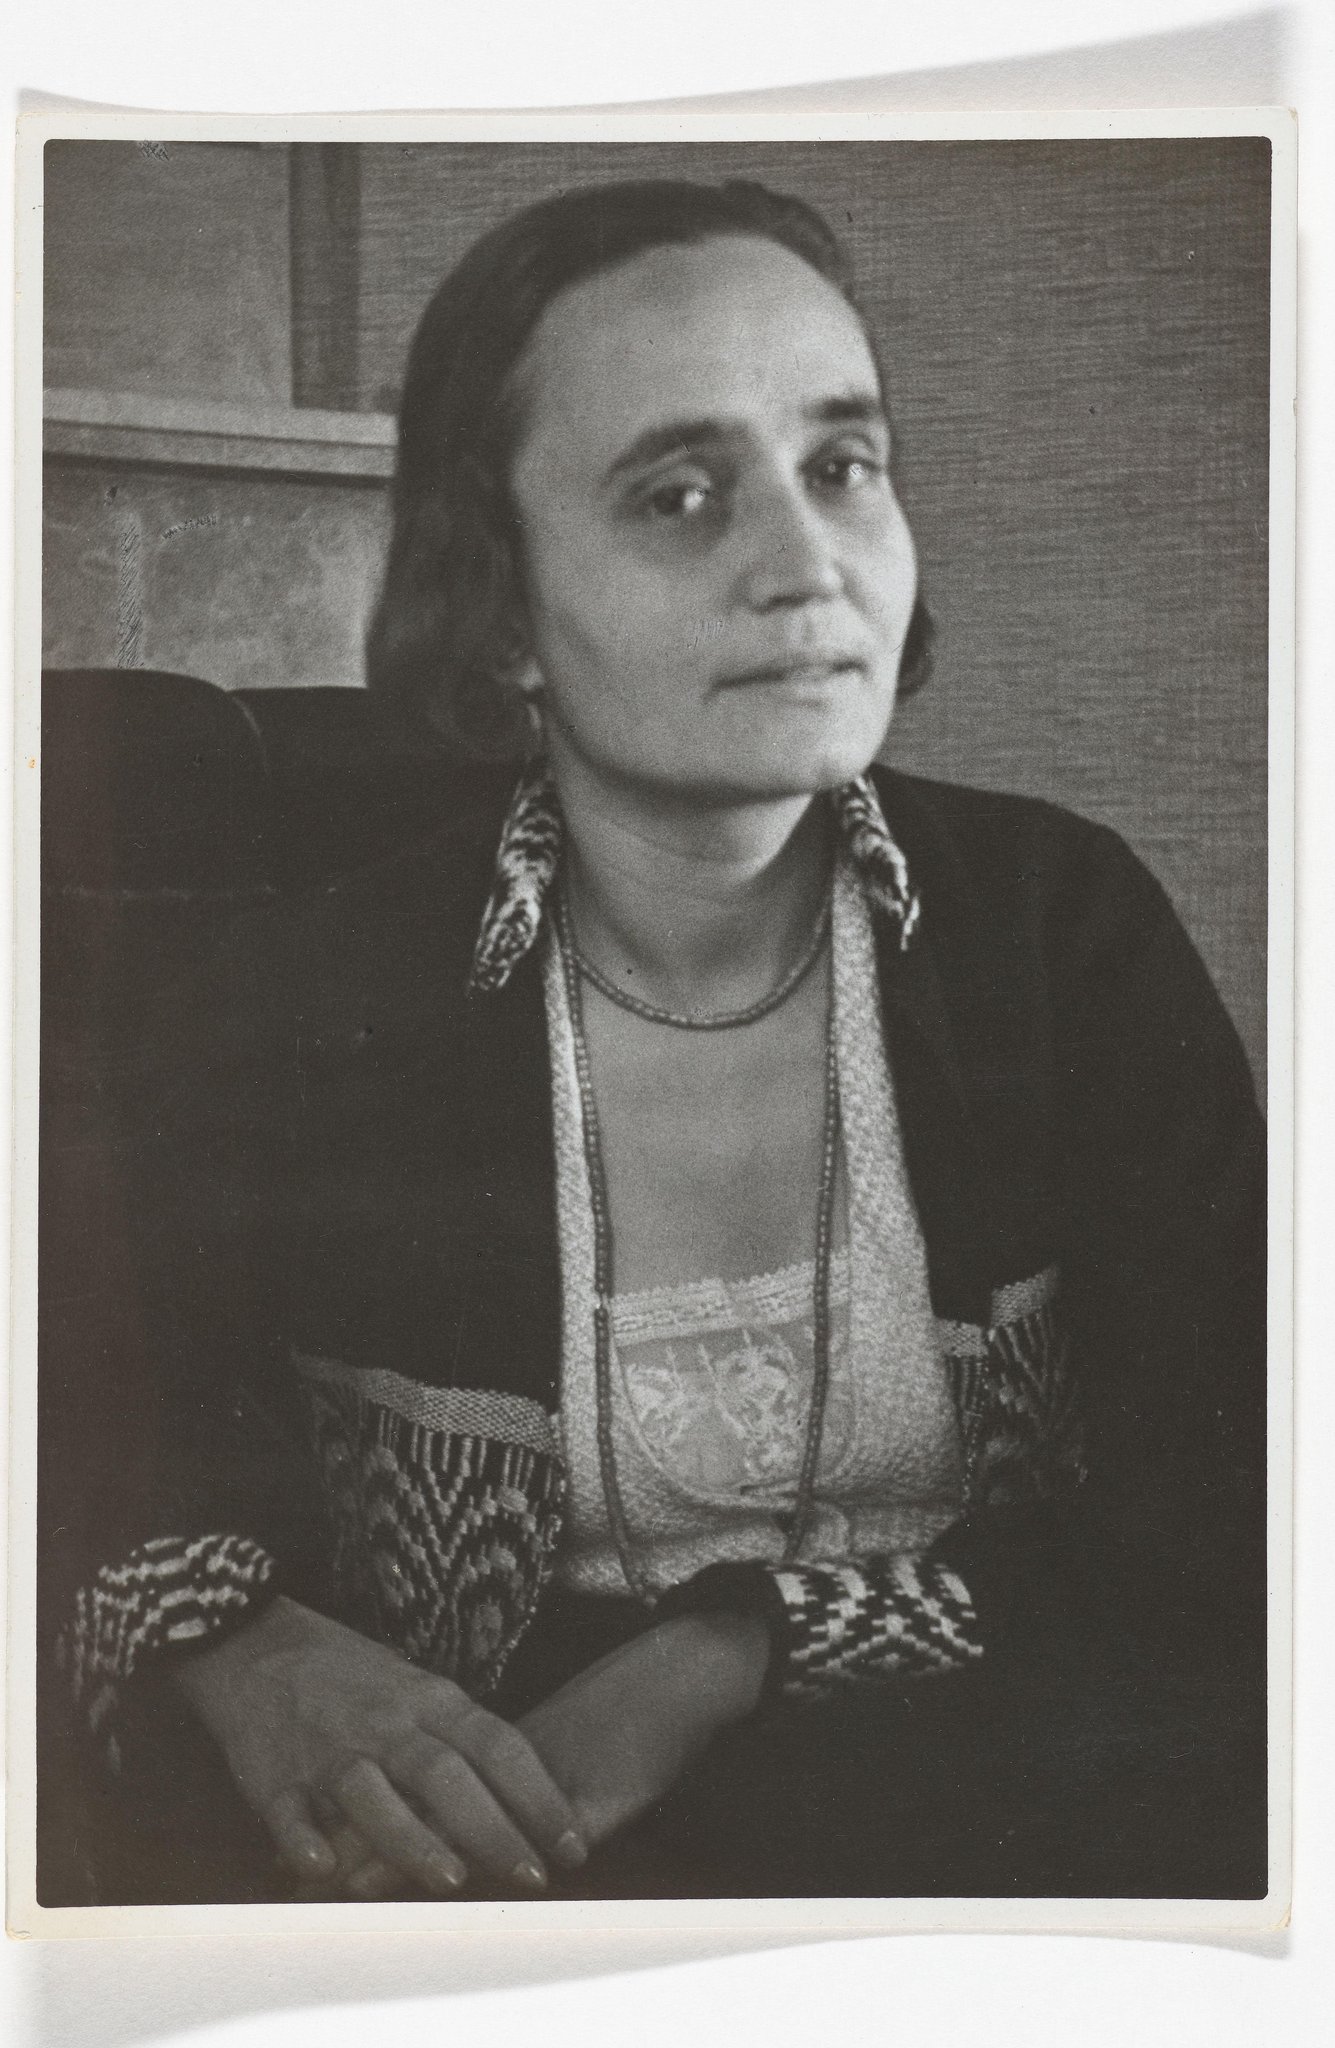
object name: photograph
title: Portret van Nel Knoop, actrice, met een door Jeanne van Gelder-Scheffer geknoopt vest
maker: kurt kahle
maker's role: fotograaf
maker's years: 1897-1953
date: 1935-1940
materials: paper, photographic support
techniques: gelatin silver print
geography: amsterdam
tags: portrait of actor, actress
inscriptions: stamp: ‘Kahle / ZUIDER AMSTELLAAN 8 / AMSTERDAM / TEL. 91675’